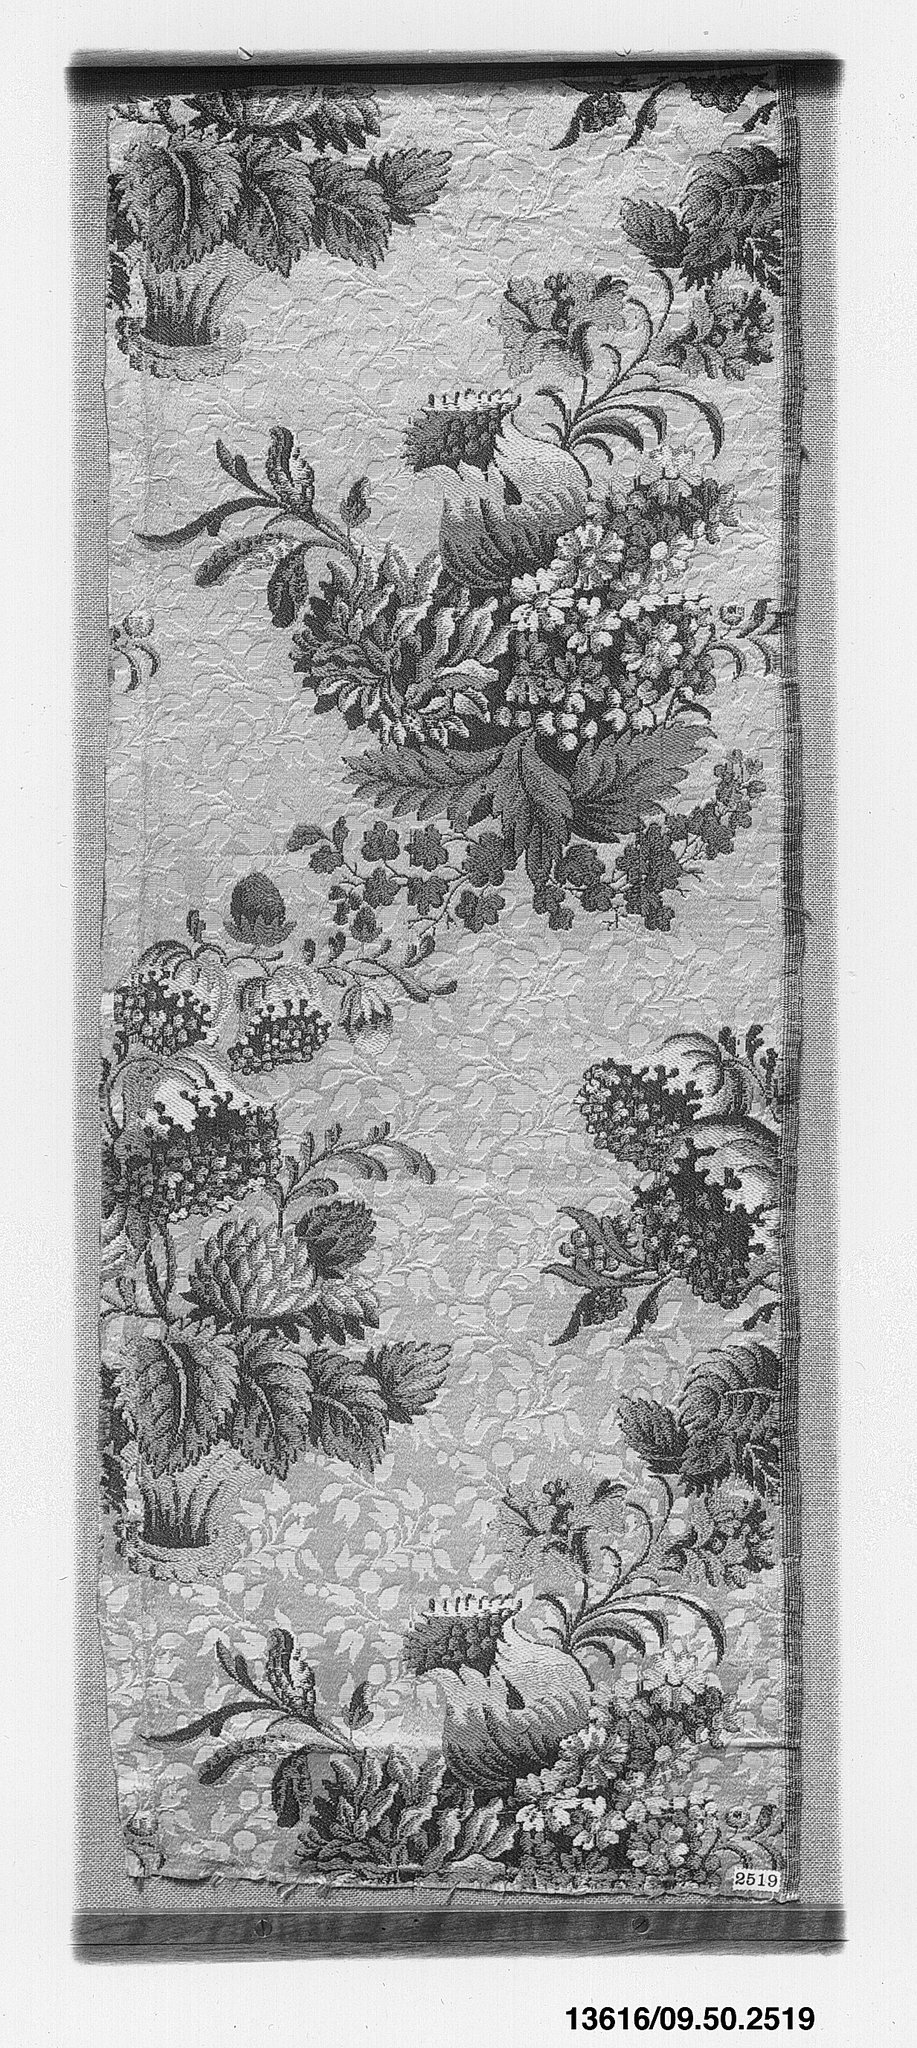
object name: piece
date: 1720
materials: silk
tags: flowers,leaves